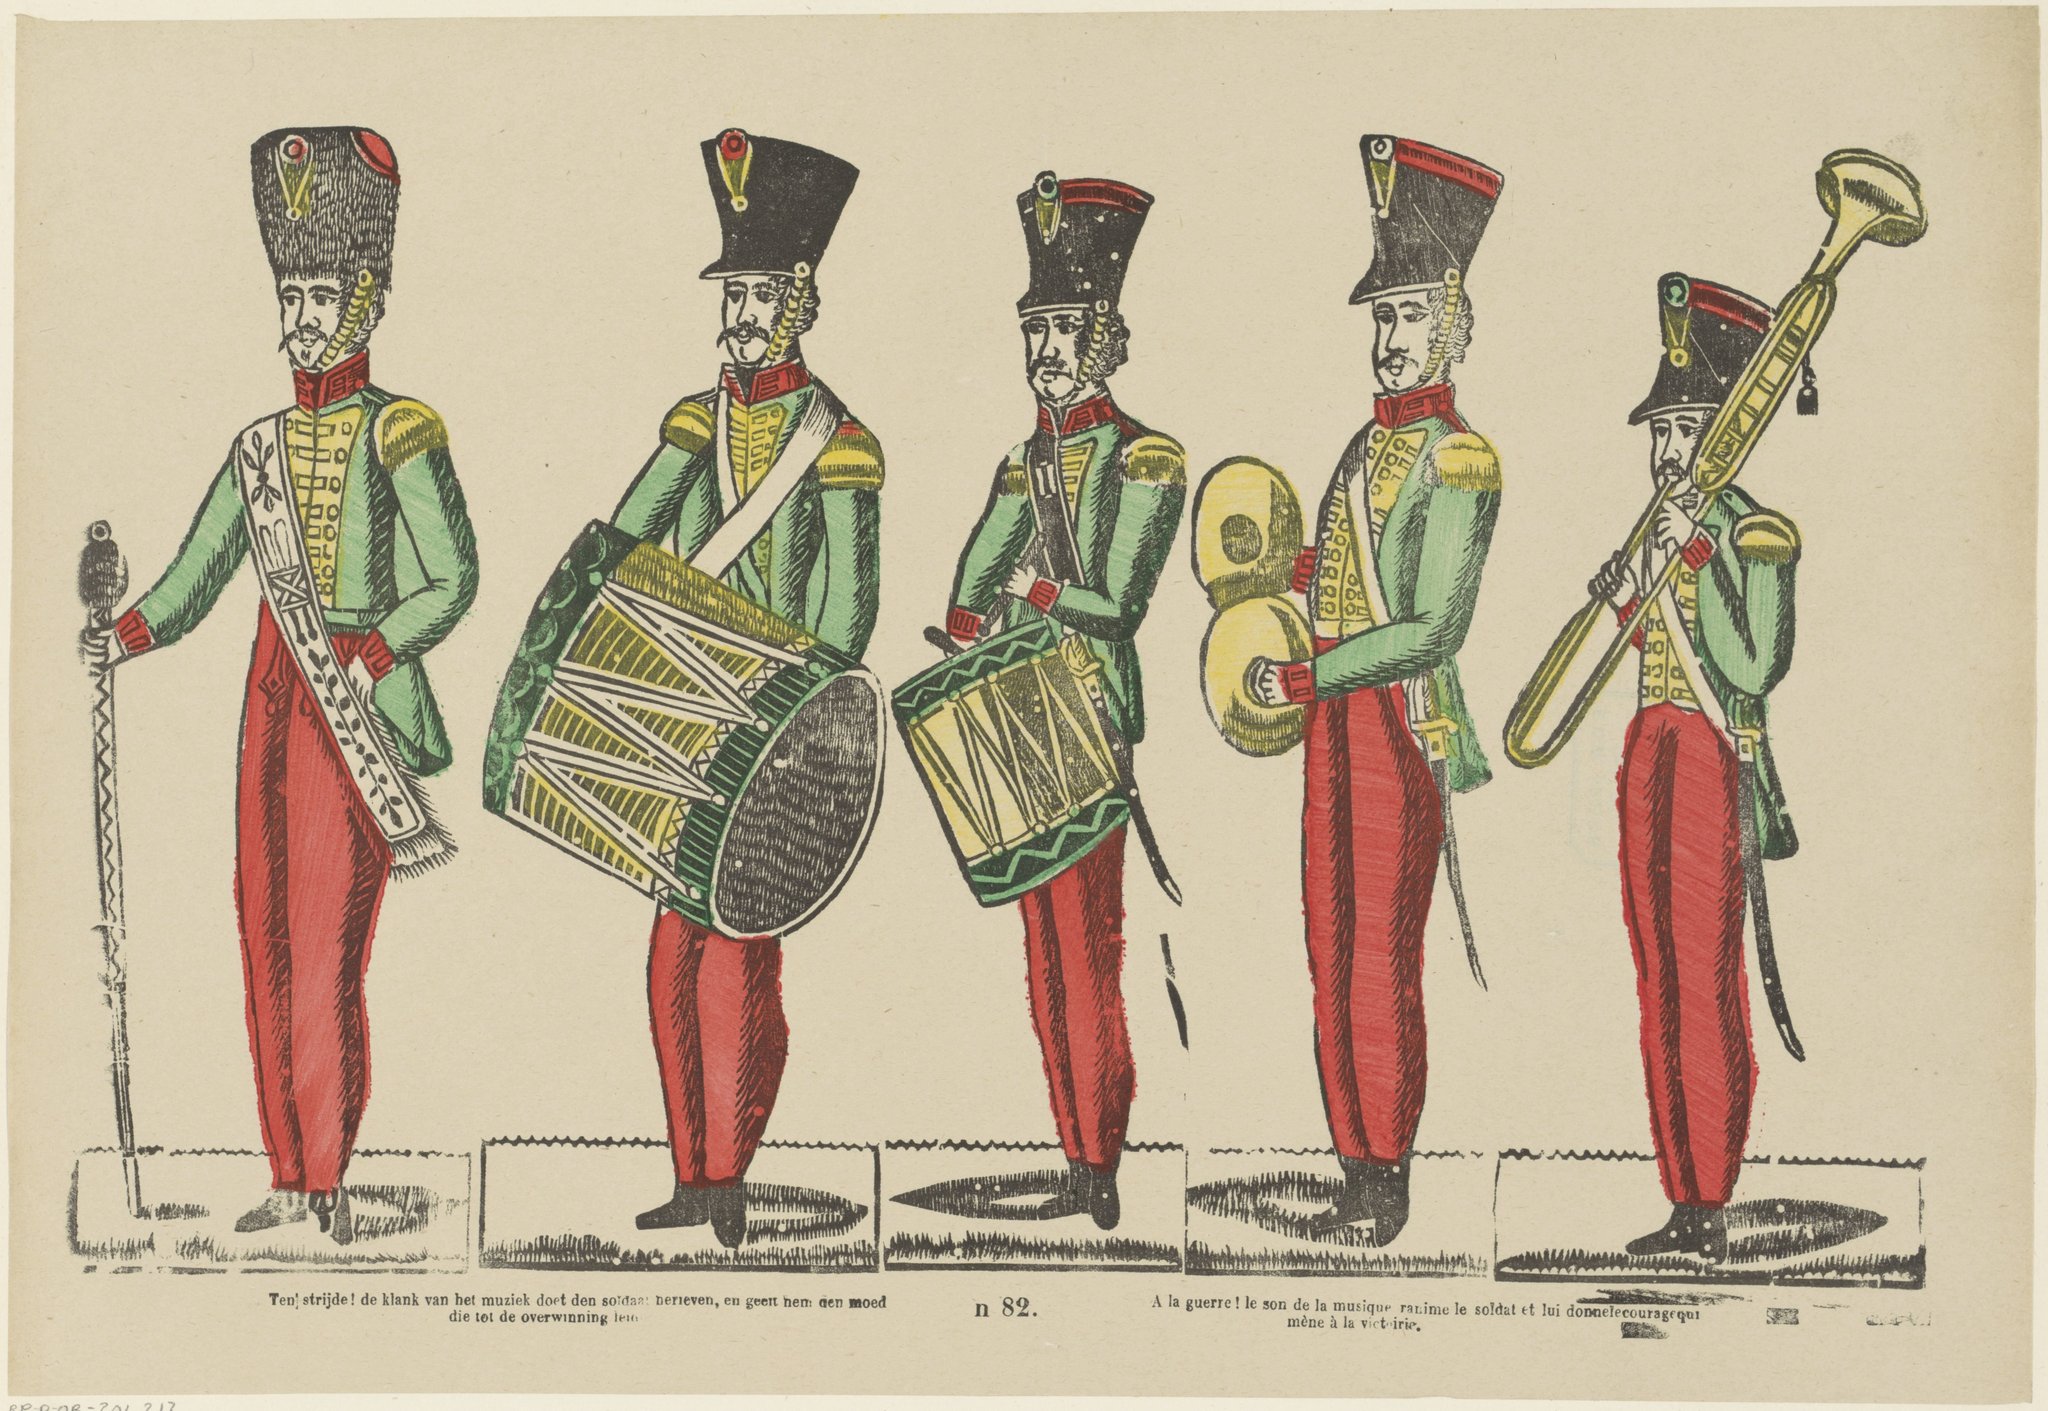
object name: print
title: Militaire band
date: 1866-1902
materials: paper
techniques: colour, letterpress printing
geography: netherlands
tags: military band, the soldier; the soldier's life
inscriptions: collector's mark: Lugt 2760, collector's mark: ‘Edw. Ipers / Oever 27, / Antwerpen.’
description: Blad met 5 staande militairen met muziekinstrumenten. Figuren om uit te knippen, op karton te plakken en aan de voet te verstevigen met een klosje hout om ze overeind te kunnen zetten. Onder de voorstellingen een tweeregelig onderschrift in het Nederlands en in het Frans. Genummerd midden onder: n 82.